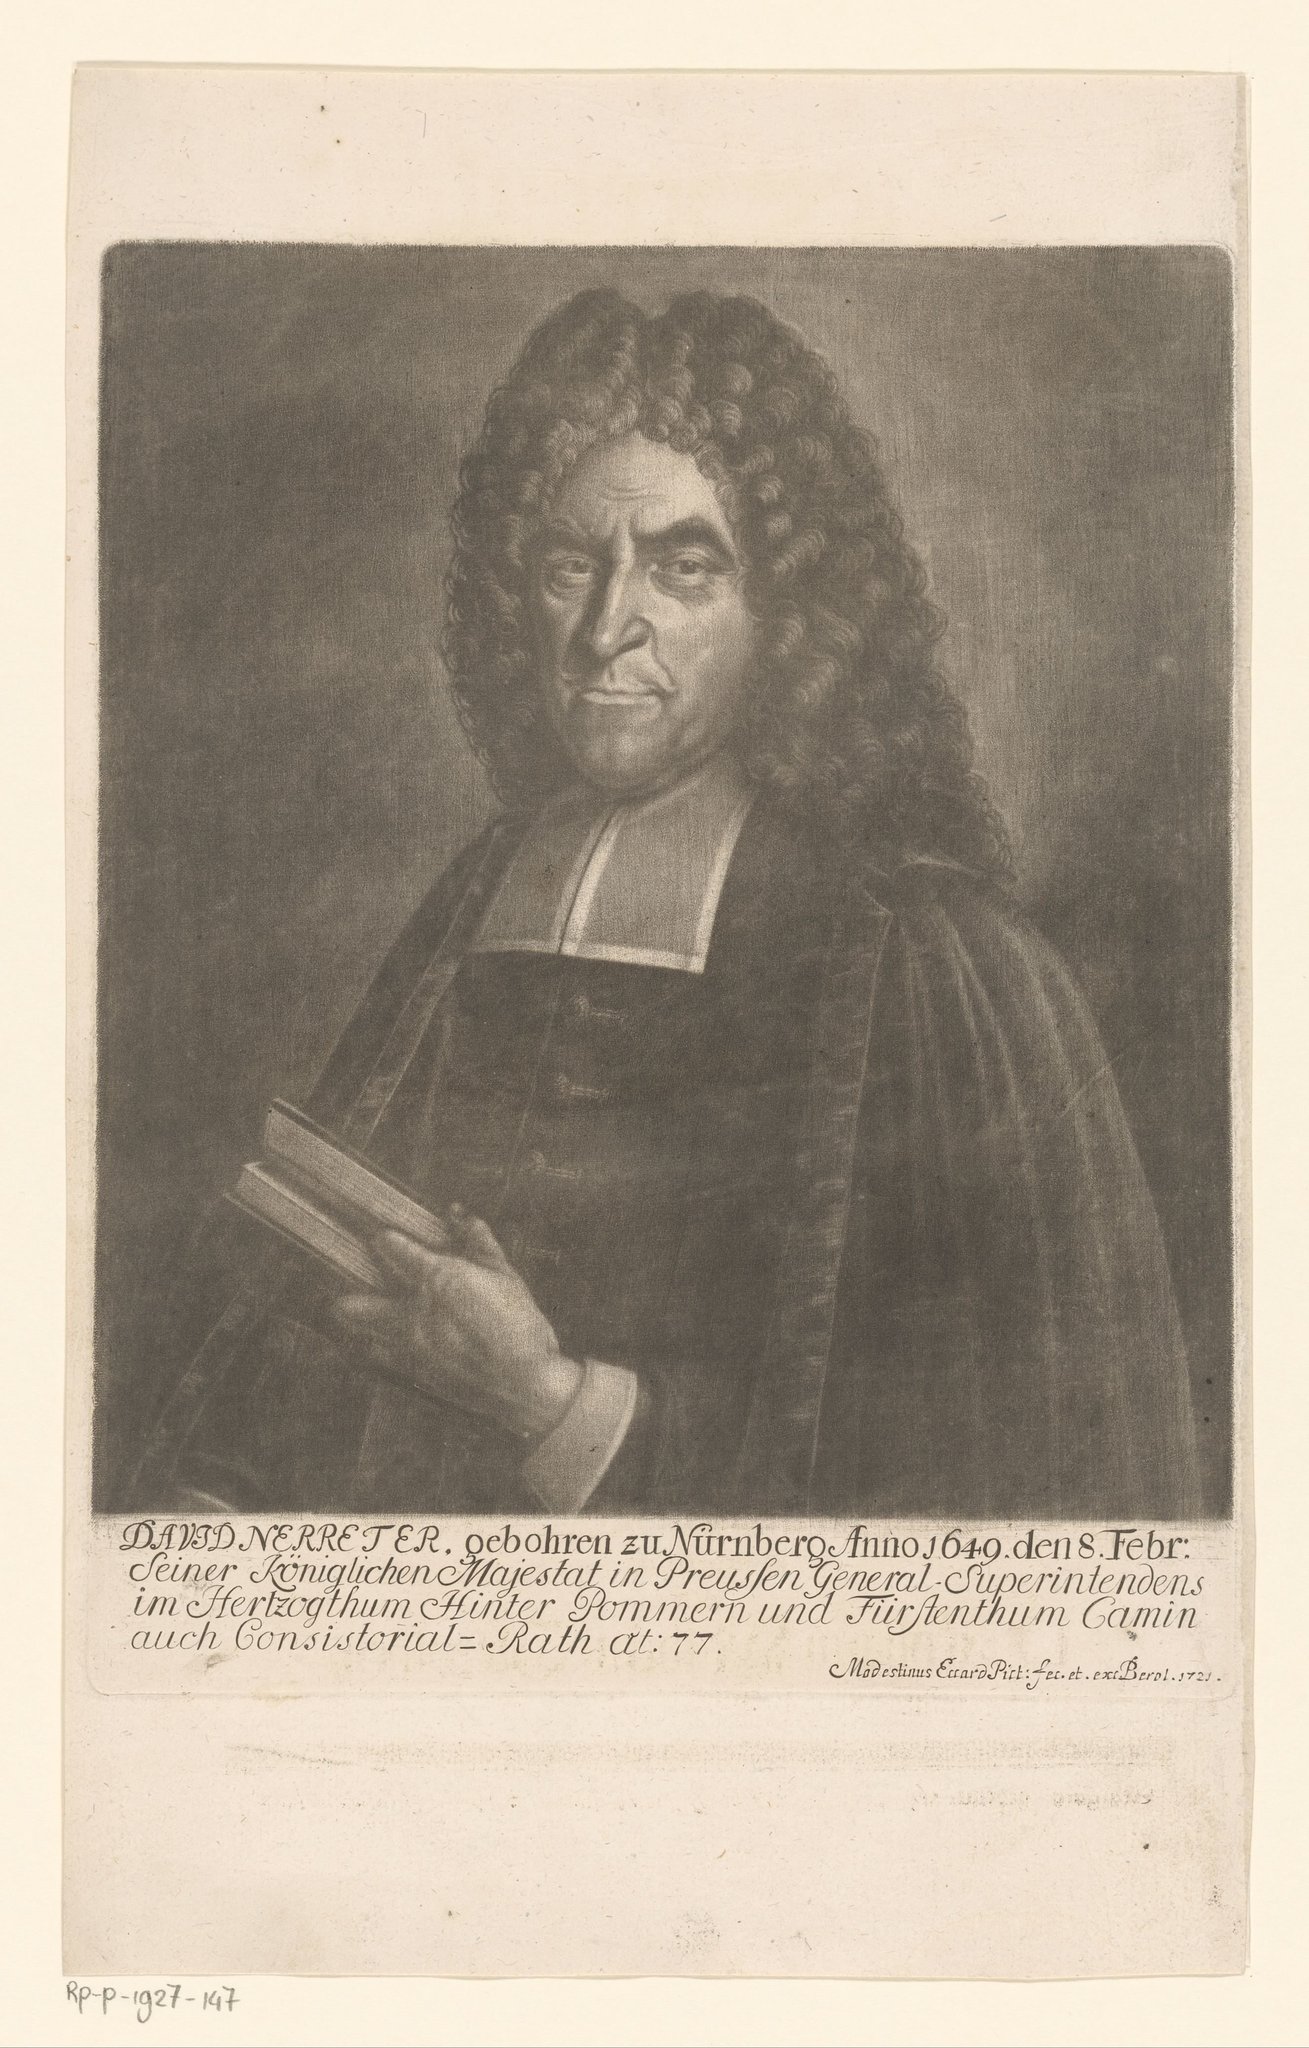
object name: print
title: Portret van David Nerreter op 77-jarige leeftijd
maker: modestin eccardt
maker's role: print maker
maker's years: 1684-1768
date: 1721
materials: paper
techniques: mezzotint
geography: berlin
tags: historical persons, book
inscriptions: collector's mark: Lugt 2166